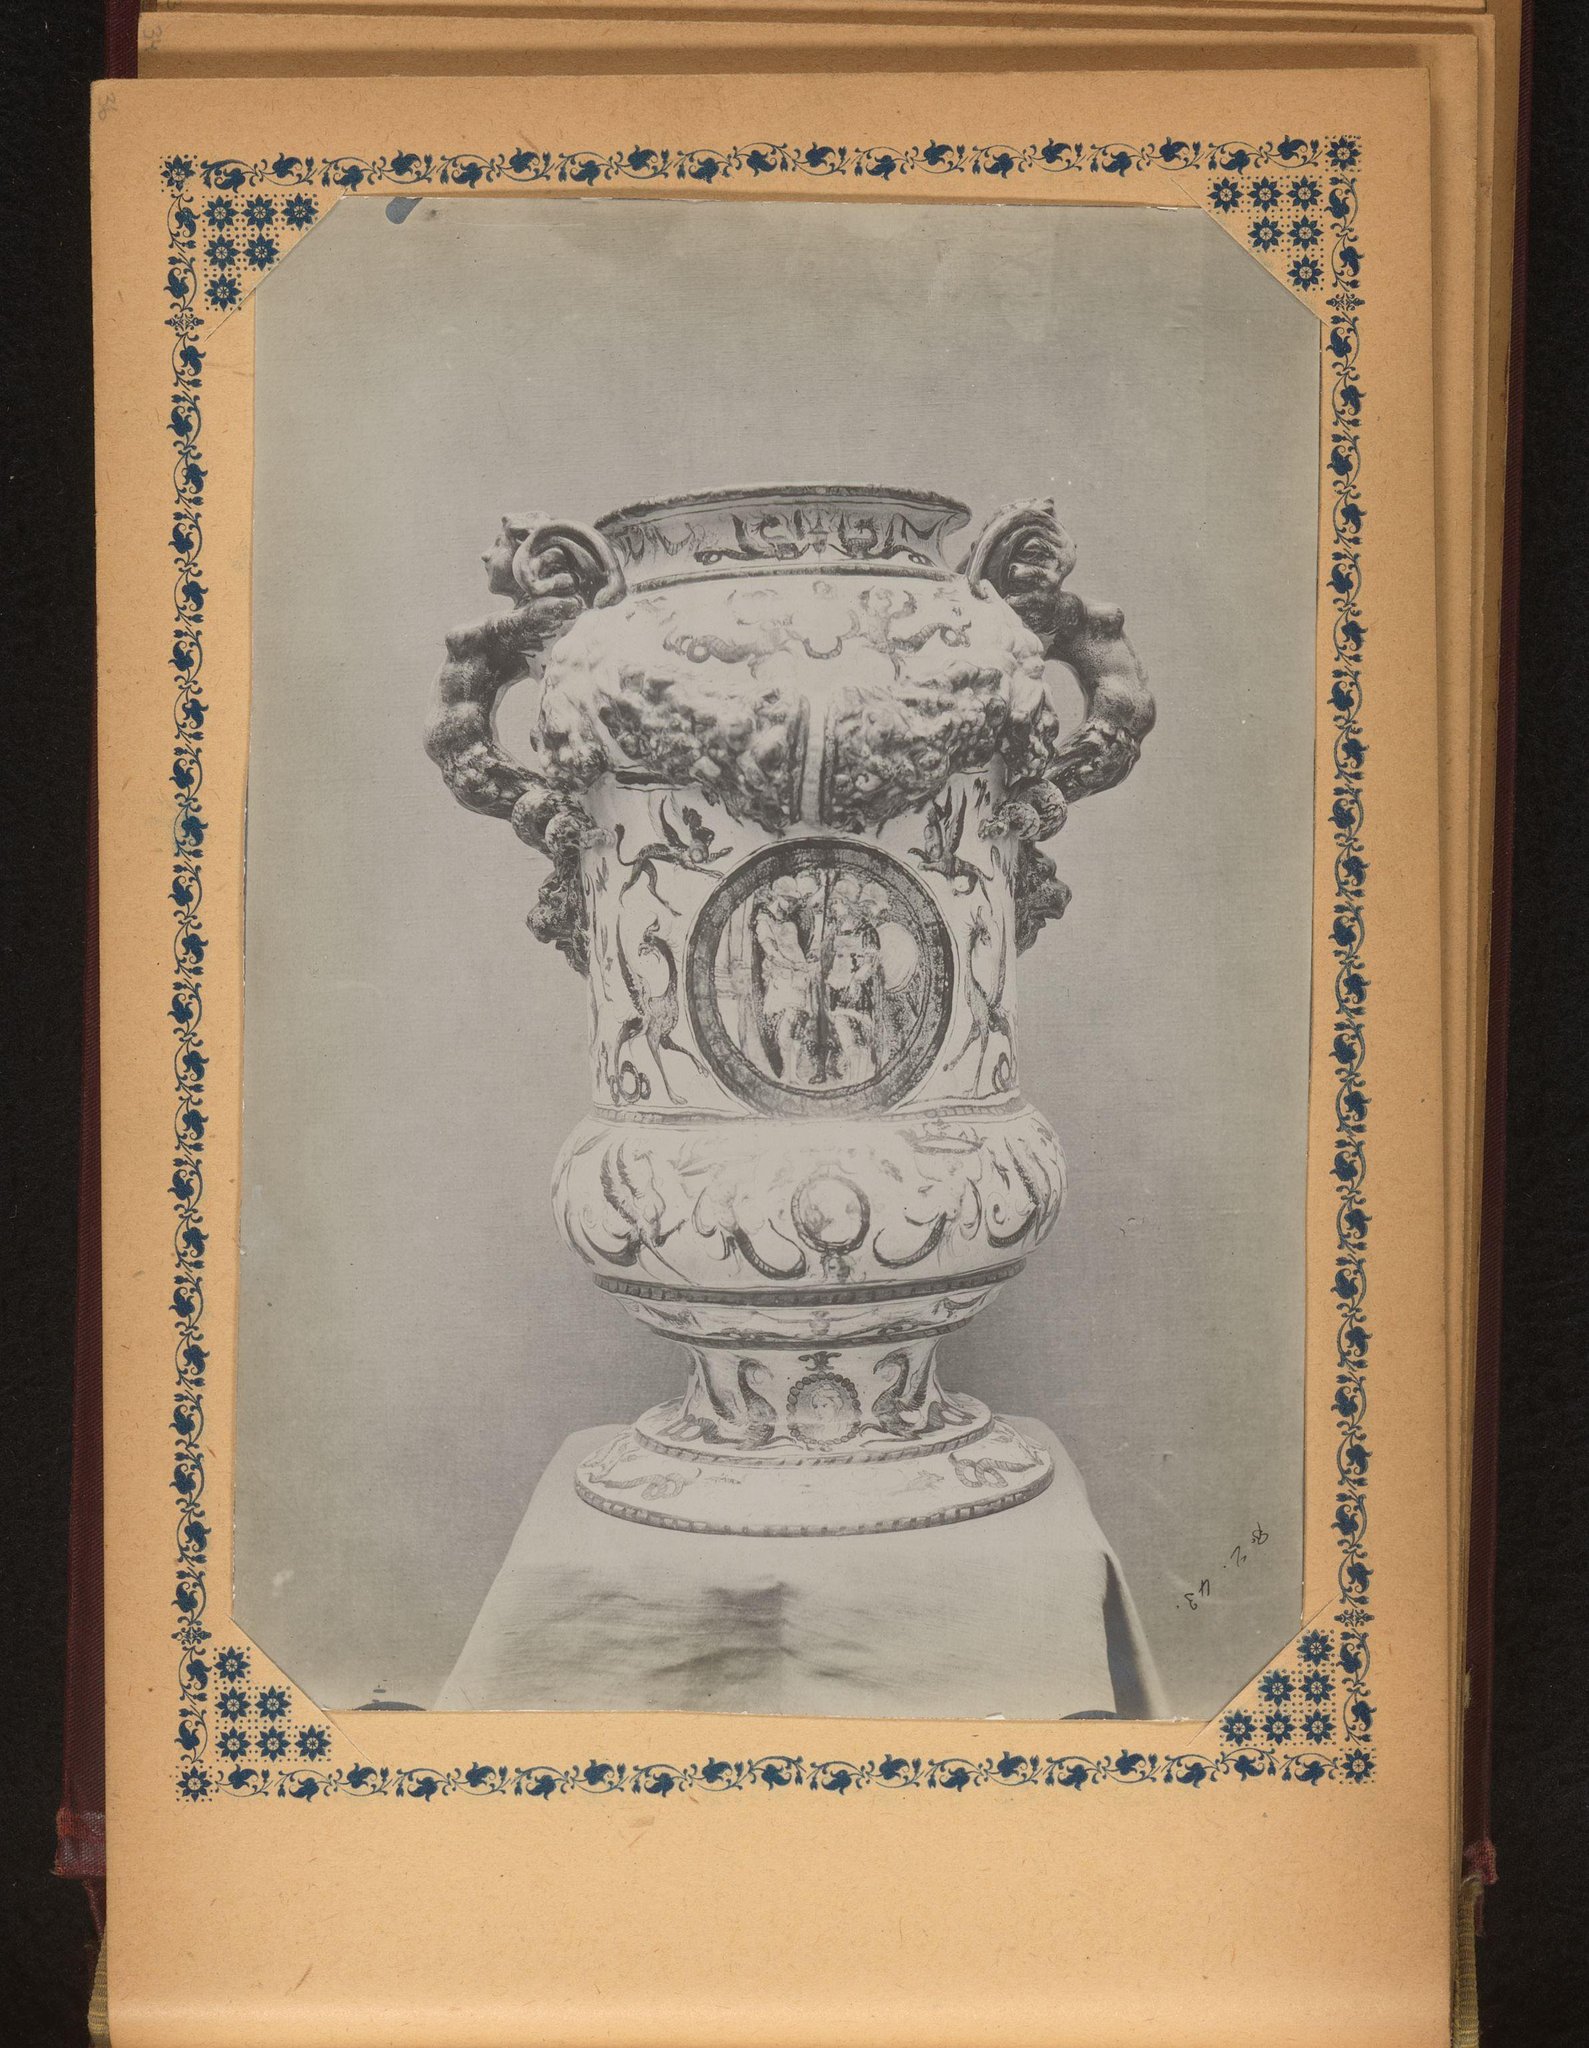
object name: album leaf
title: Vaas beschilderd met figuren en mythologische dieren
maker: Anonymous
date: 1880-1940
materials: cardboard, photographic support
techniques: gelatin silver print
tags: fabulous animals (sometimes wrongly called 'grotesques'); 'mostri' (ripa), the (nude) human figure; 'corpo humano' (ripa), container of ceramics: jar, jug, pot, vase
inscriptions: number: ‘B. 2. 43.’